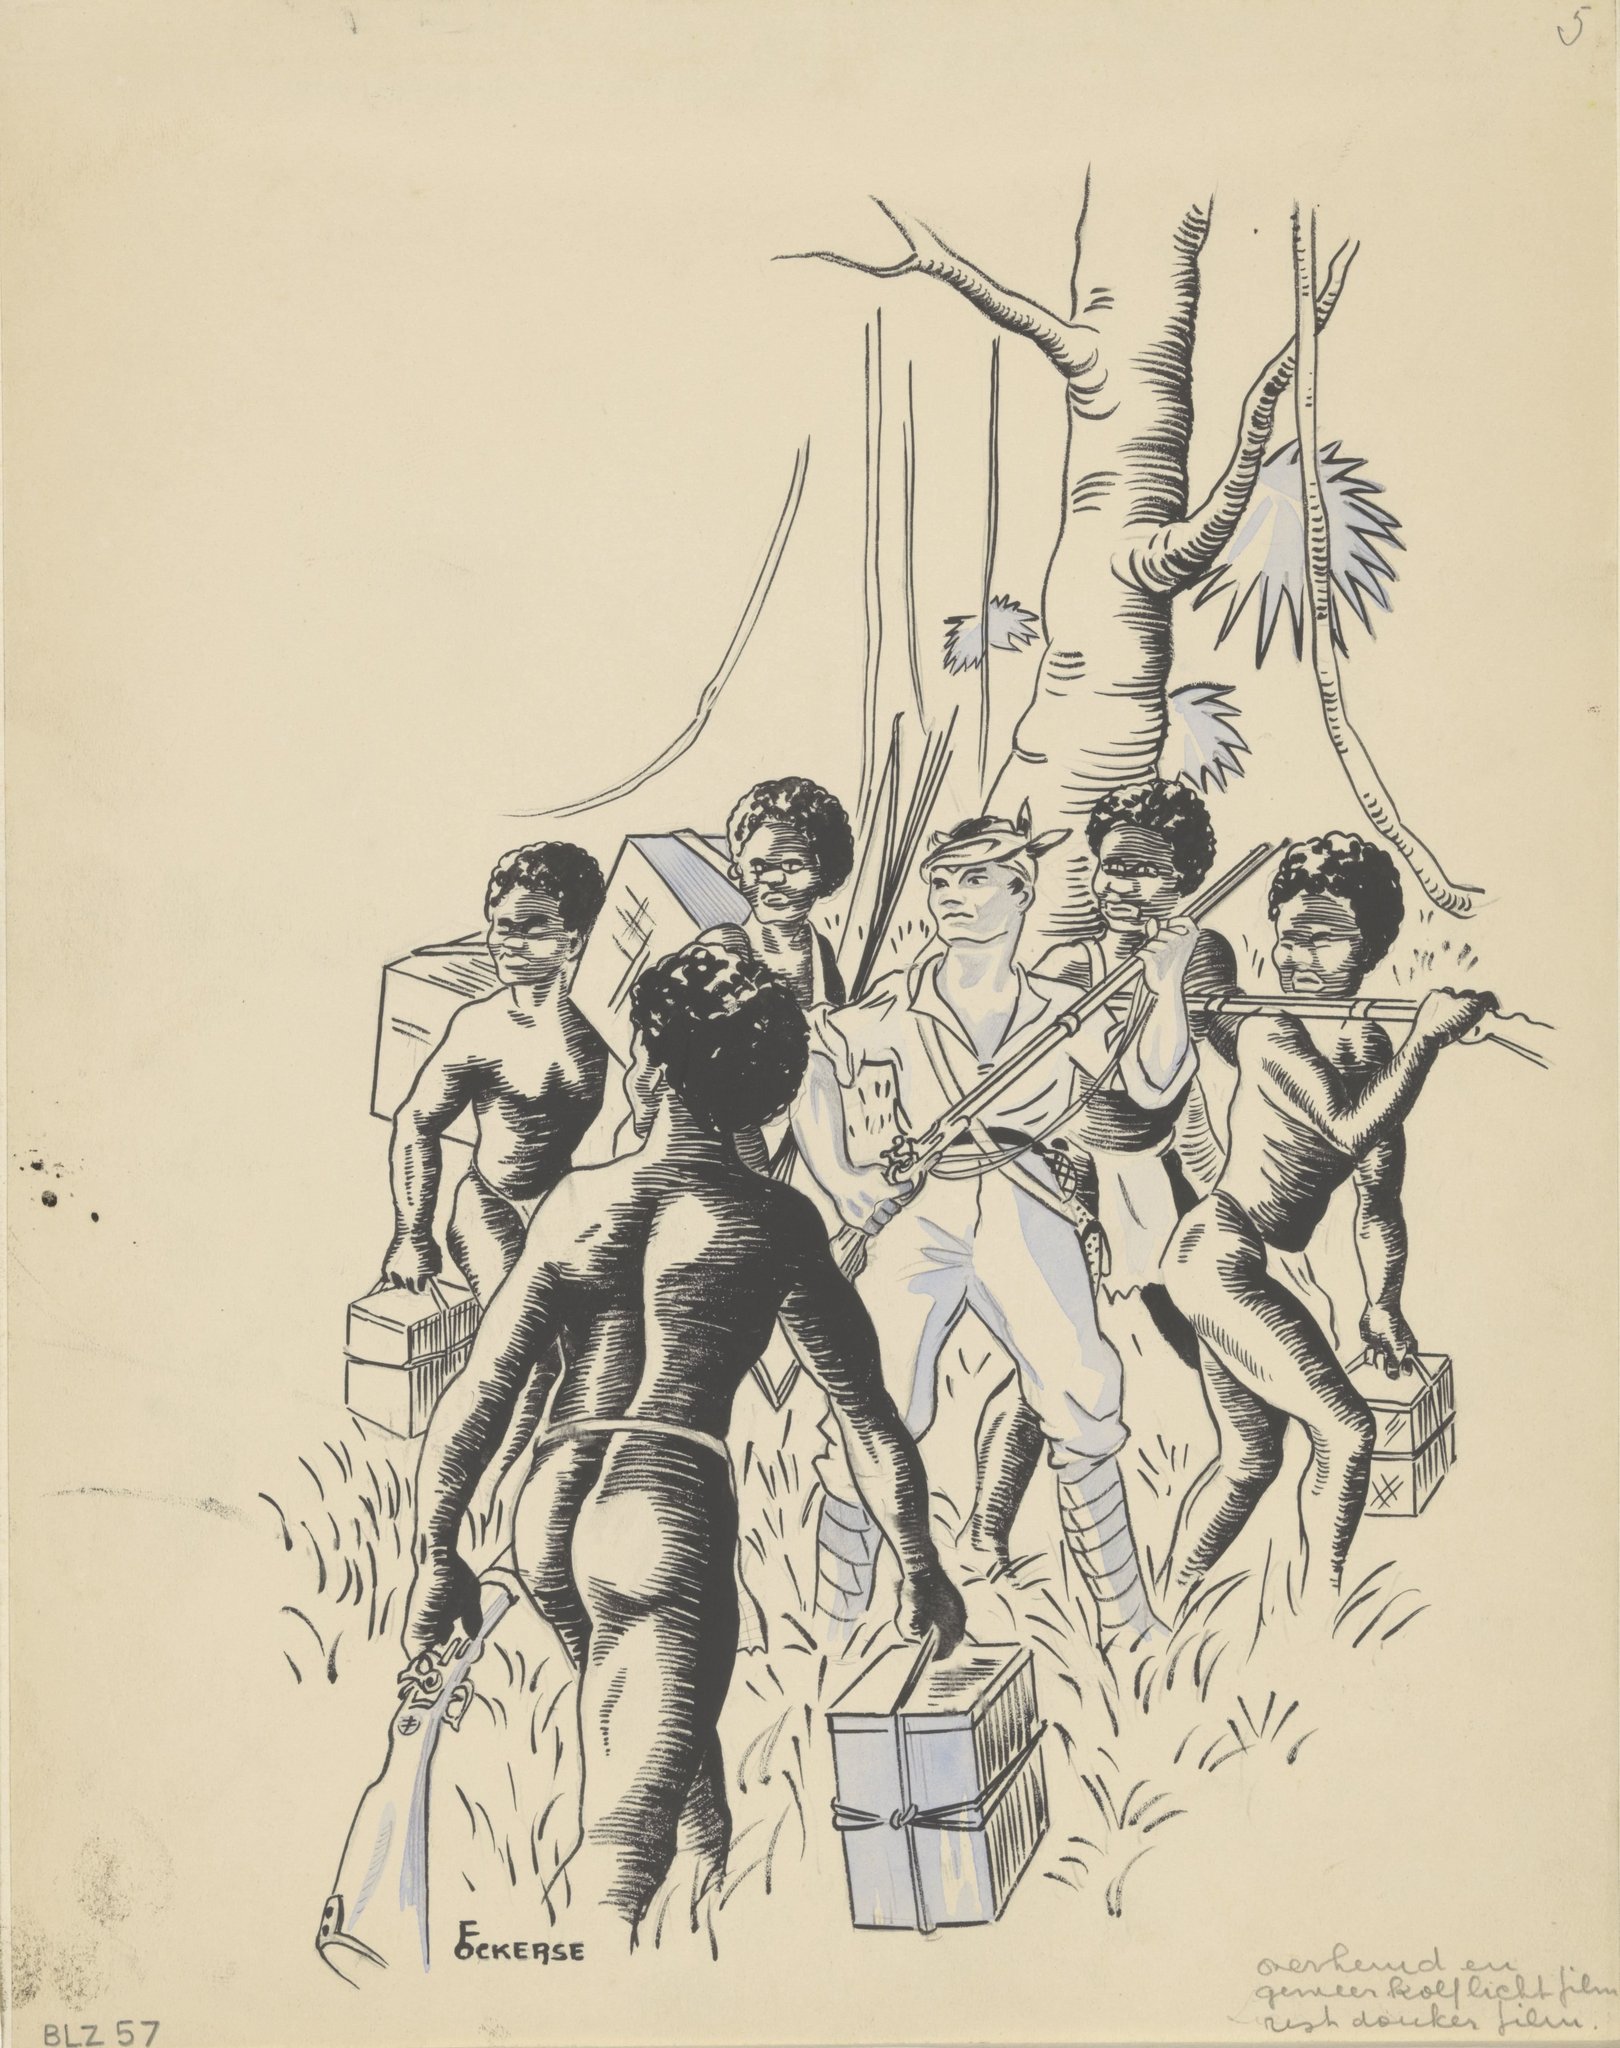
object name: boekillustratie ontwerp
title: Witte man met vuurwapen tussen de Nieuw-Guineeërs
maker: f. ockerse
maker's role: draughtsman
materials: paint, paper, pencil, watercolor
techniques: brush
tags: carrying something, folk costume, regional costume, firearms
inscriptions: :, signature: ‘F/ OCKERSE’, annotation: ‘5/ BLZ. 57’, collector's mark: Lugt 2228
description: De man draagt een overhemd, broek en laarzen en heeft een vuurwapen in de hand. Rond hem staan vijf Nieuw-Guineeërs in lendendoeken die wapens en dozen dragen.